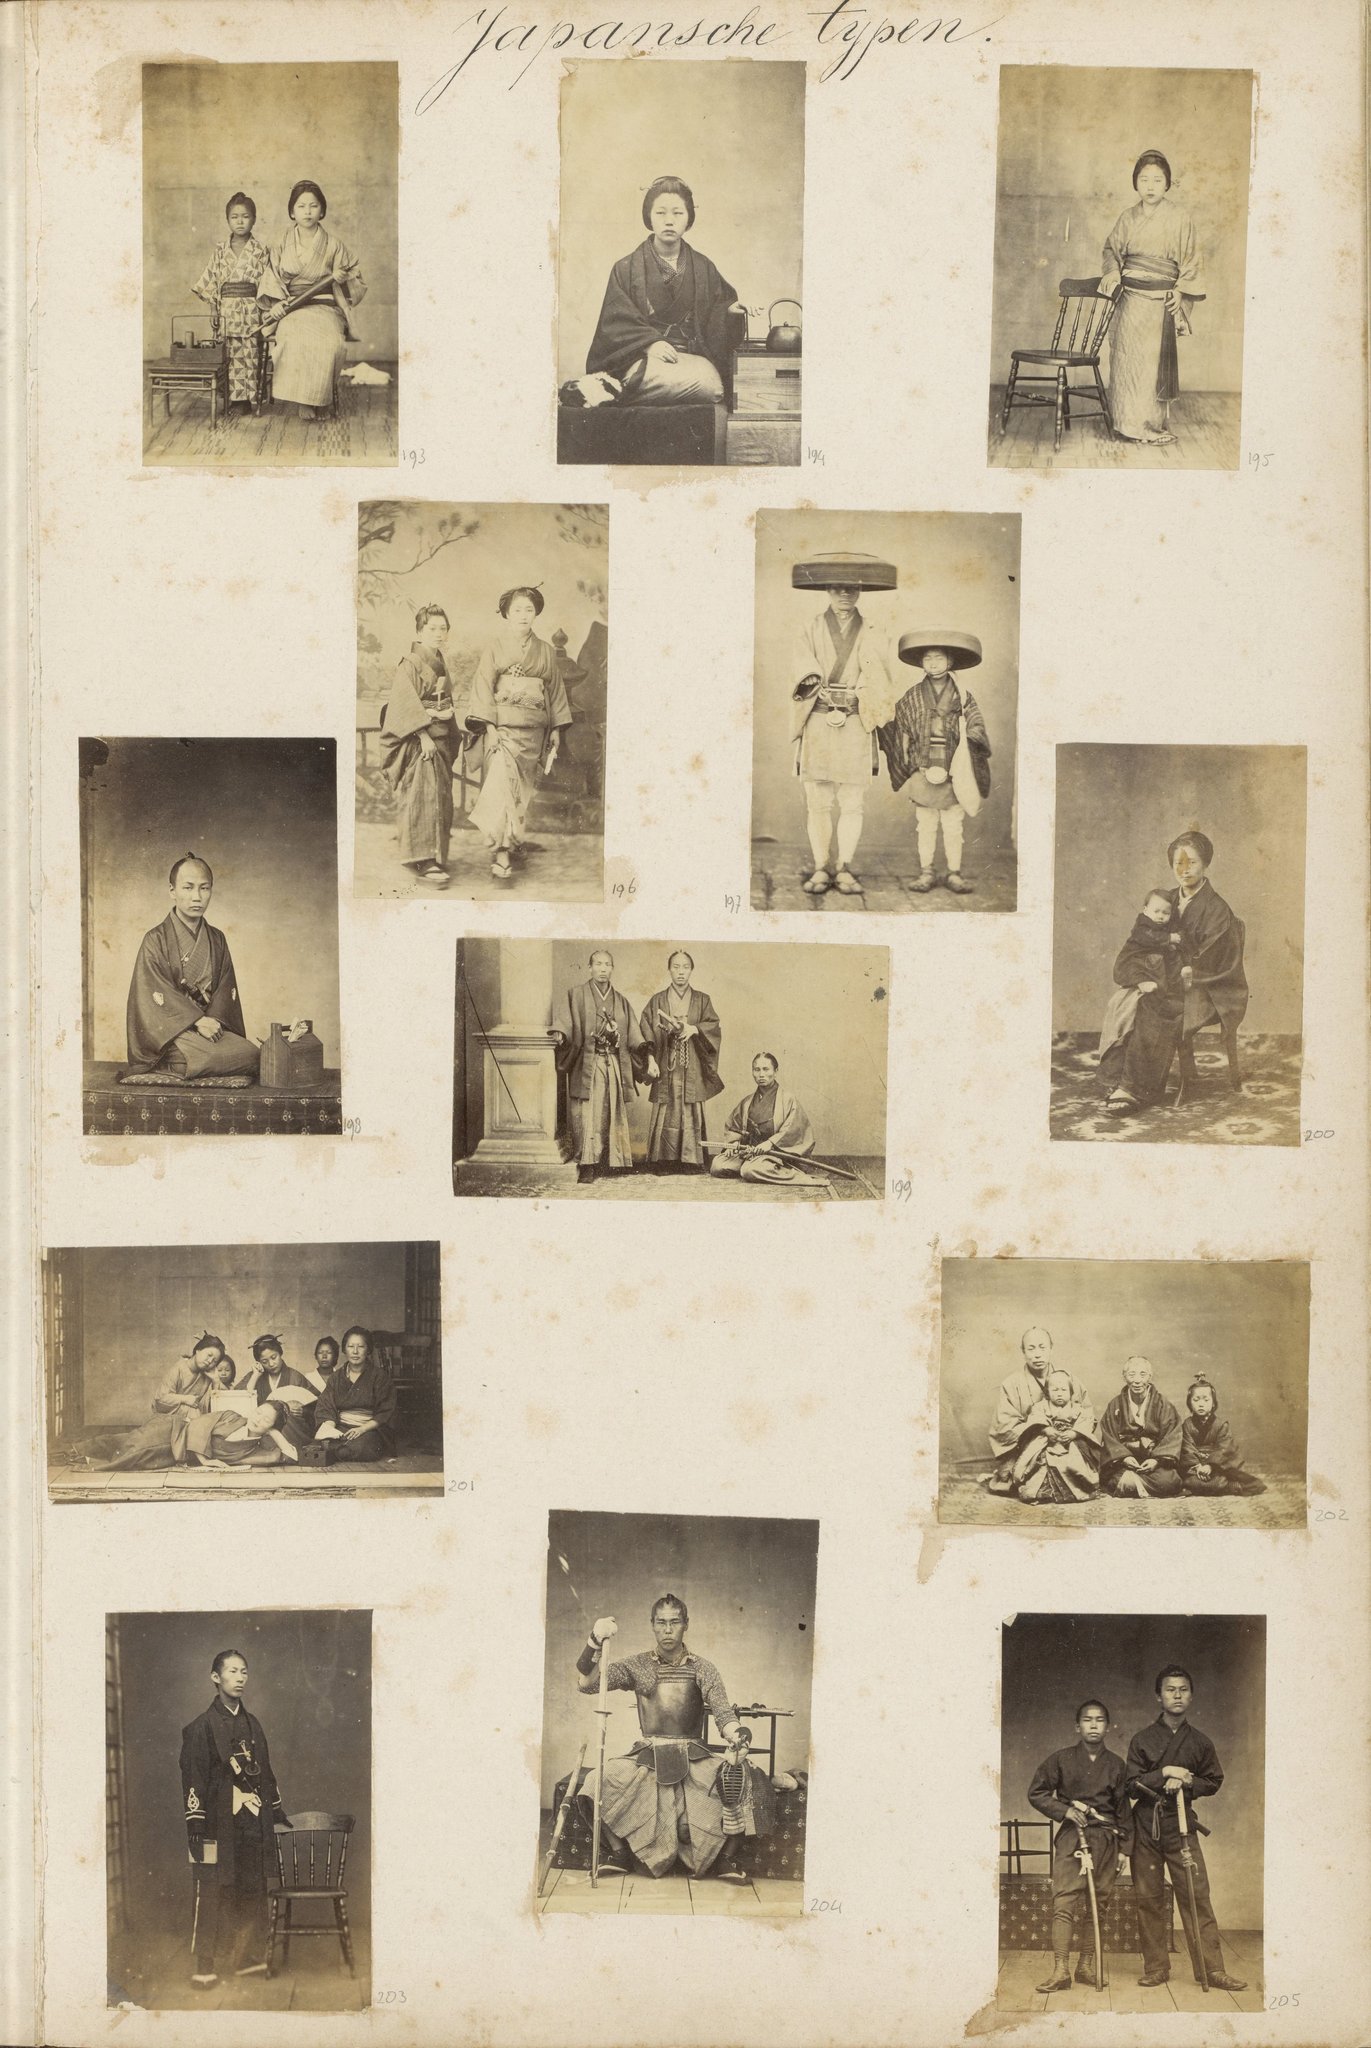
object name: album leaf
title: Portret van een jonge Japanse vrouw en een kind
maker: Anonymous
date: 1870-1880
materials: paper, photographic support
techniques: albumen print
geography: japan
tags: studio requisites ~ photographer, mother and baby or young child, japan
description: Onderdeel van Fotoalbum van Robert Daniel Crommelin (1841-1907).